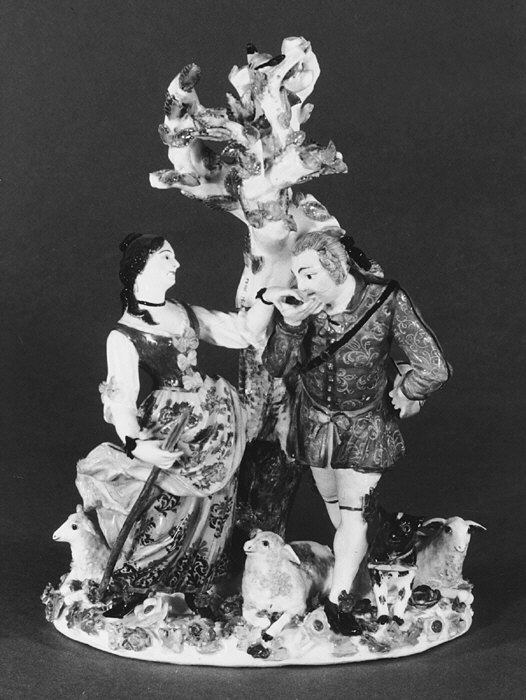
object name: group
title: Shepherd lovers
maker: meissen manufactory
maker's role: manufactory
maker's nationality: german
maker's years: 1710-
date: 1738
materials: hard paste porcelain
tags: men,lovers,women,sheep